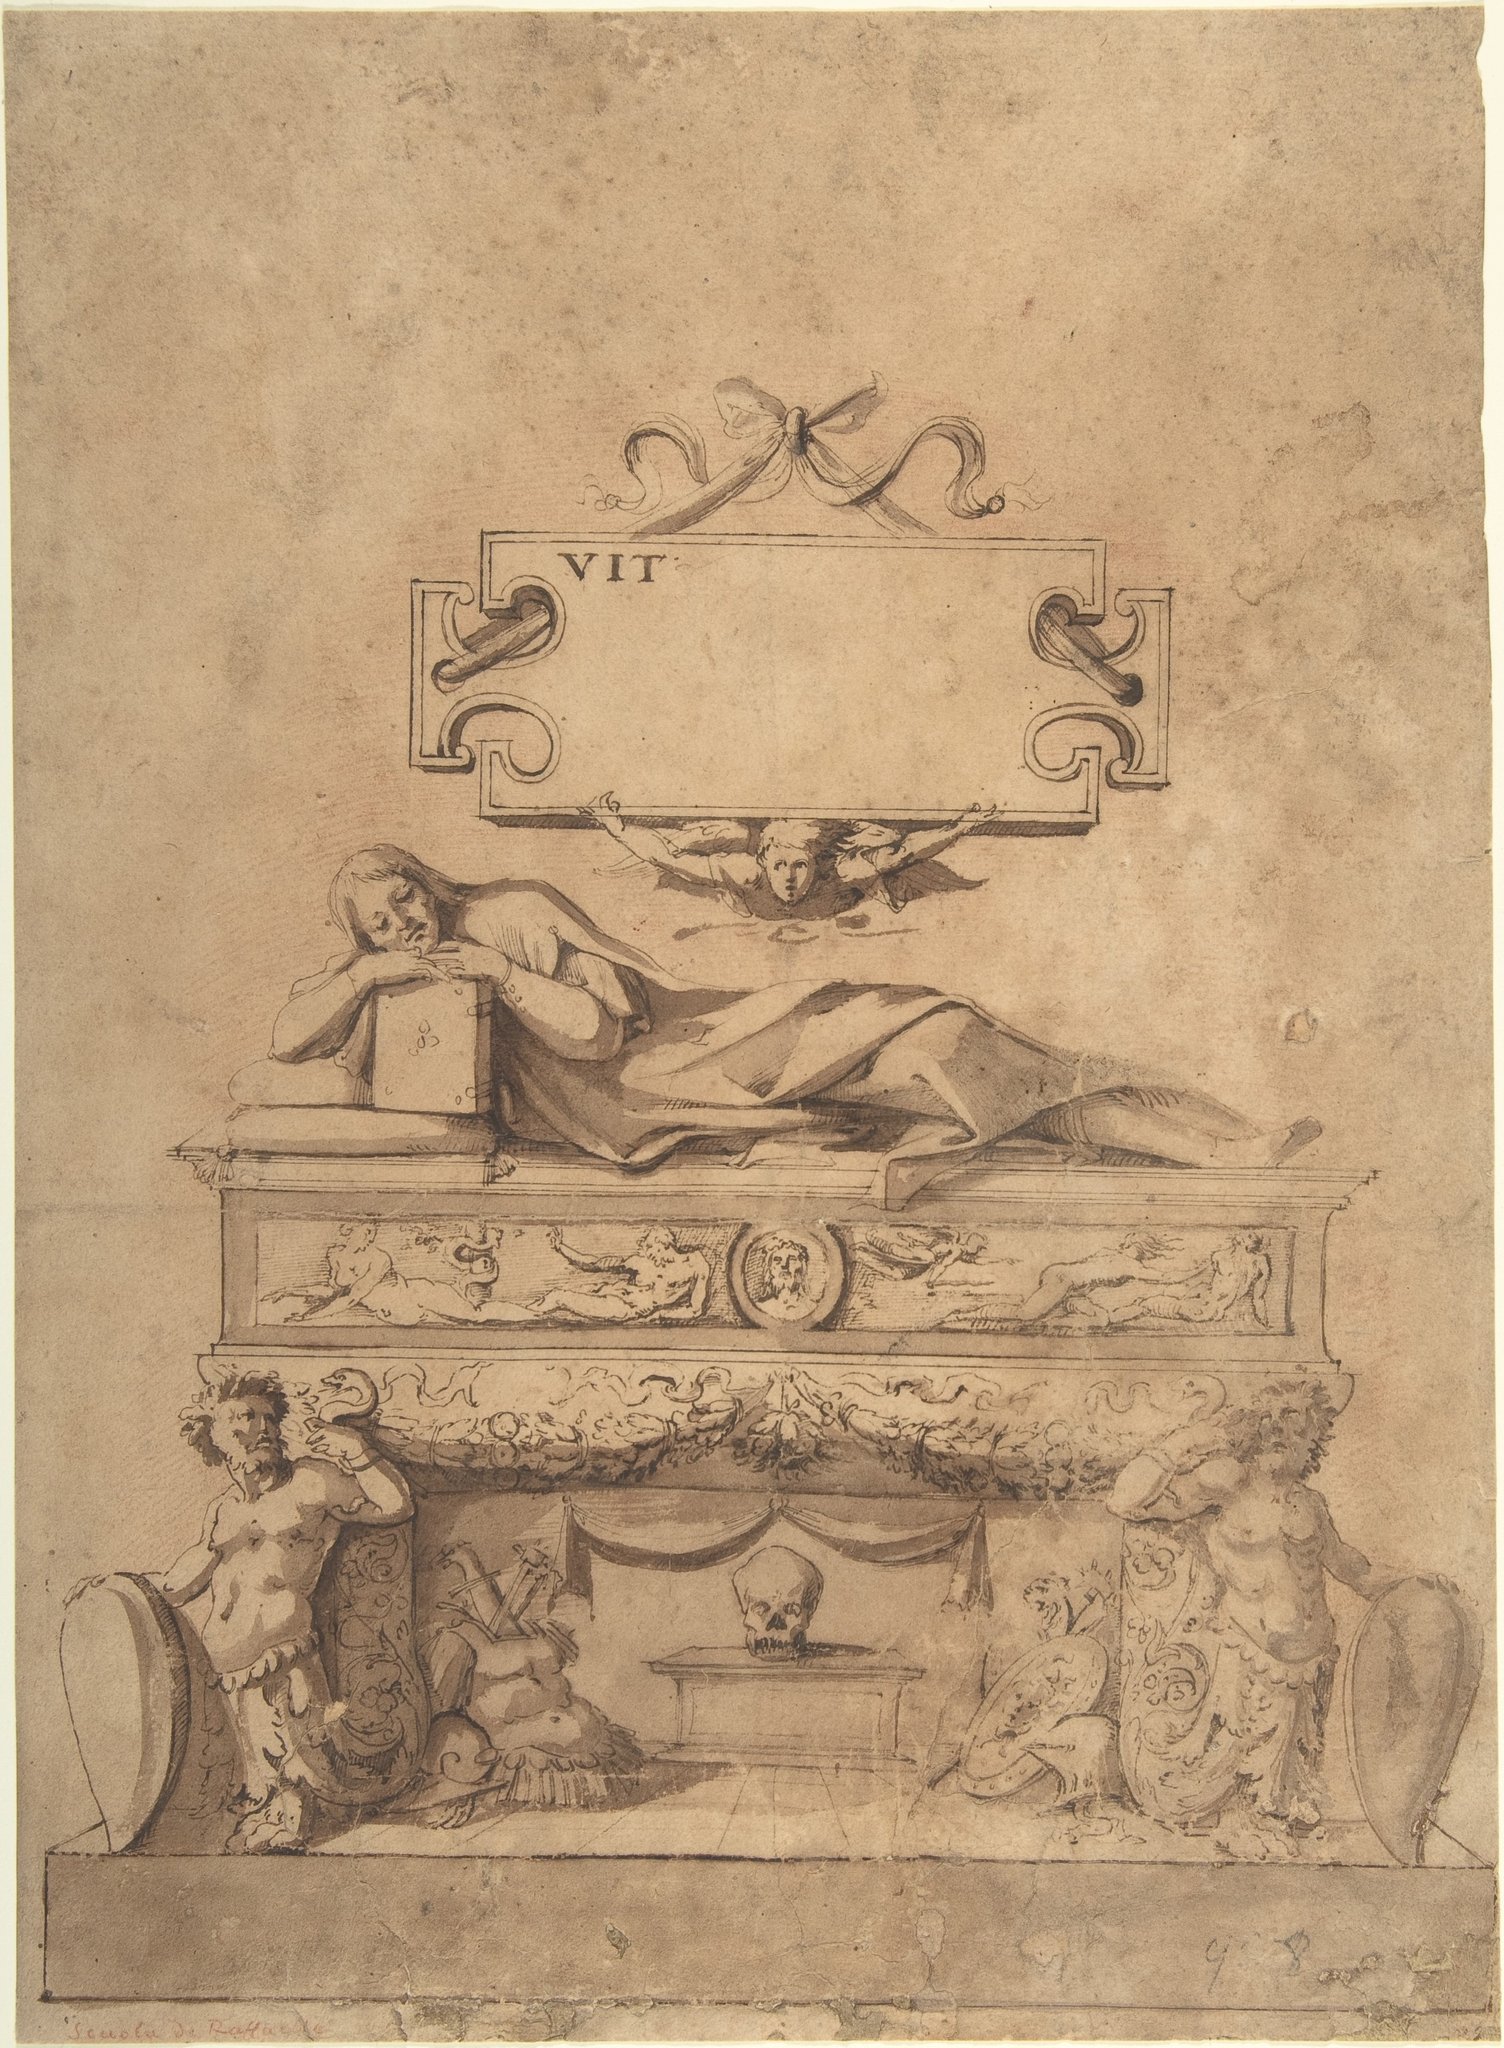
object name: drawing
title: Tomb Design with Reclining Figure on Sarcophagus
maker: anonymous, italian, 16th century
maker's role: artist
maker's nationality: italian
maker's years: 1500-1600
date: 1501-1600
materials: ink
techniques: brush, pen, wash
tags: tombs,skulls,men,women